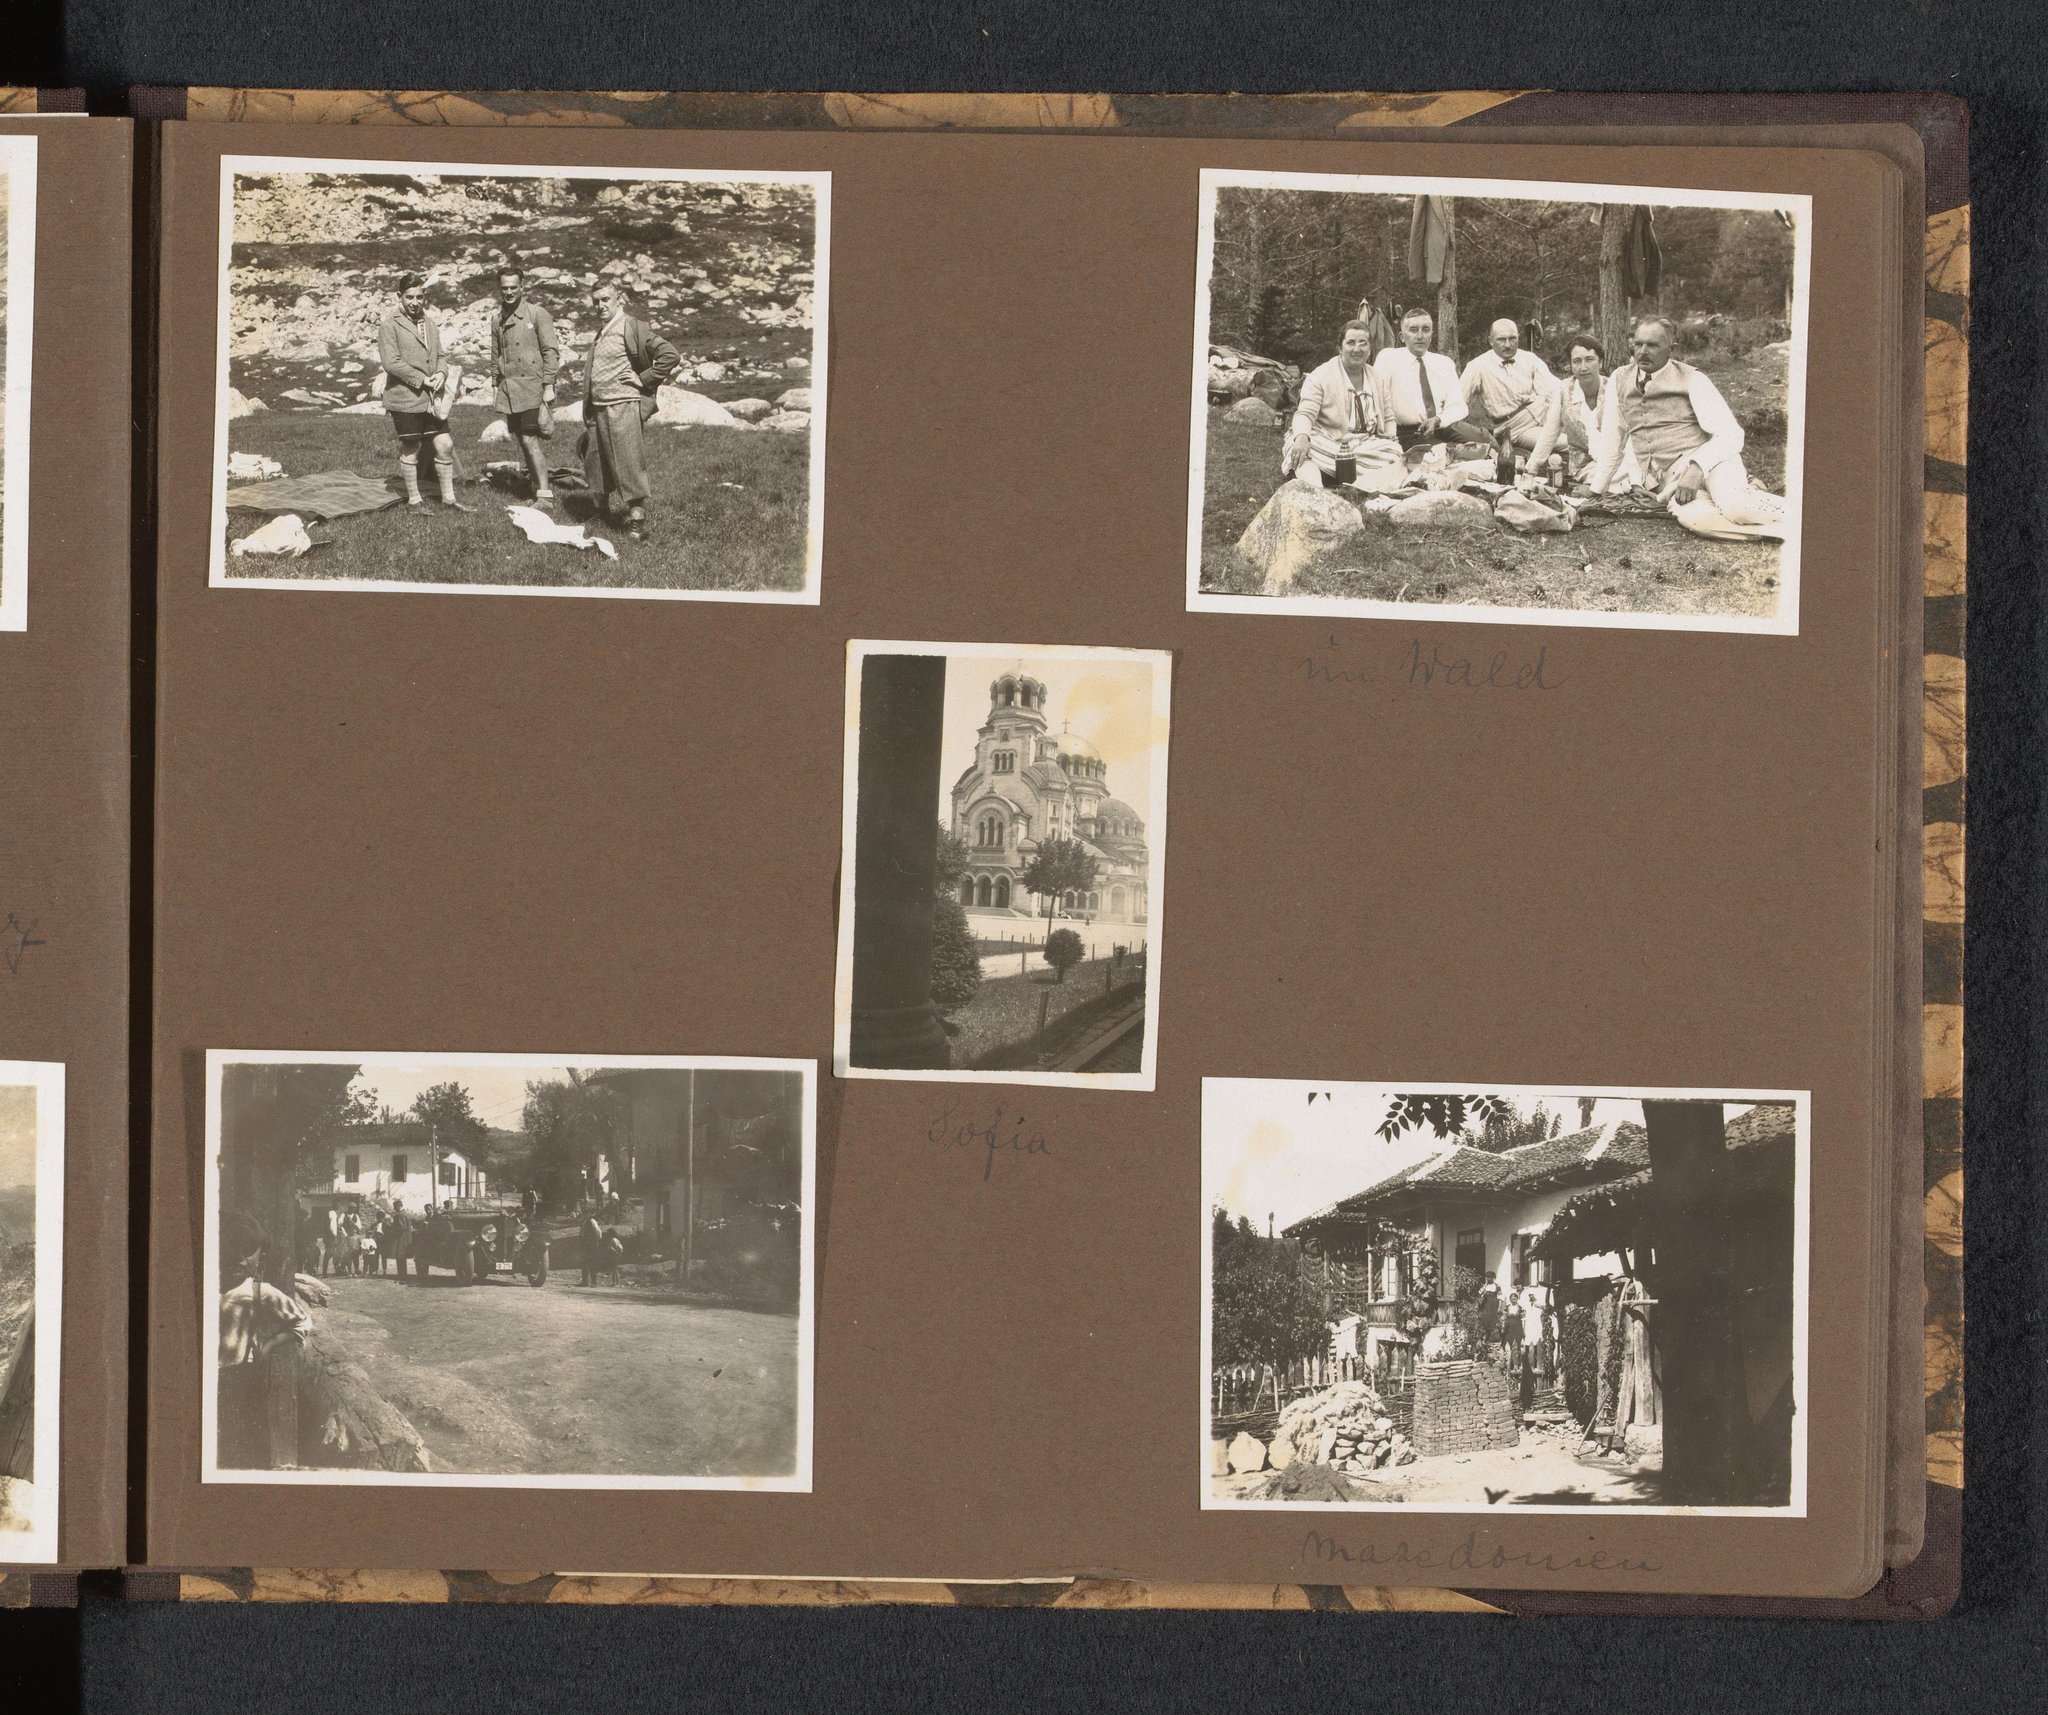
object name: photograph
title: Eugen Wachenheimer en Else Wachenheimer-Moos in Bulgaarse landschappen met onbekende mannen, tijdens een rondreis van Eugen met zijn echtgenote Else Wachenheimer-Moos door Bulgarije, 1926-1927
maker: else wachenheimer-moos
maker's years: 1895-1944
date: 1926-1927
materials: paper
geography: bulgaria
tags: eugen wachenheimer, else wachenheimer-moos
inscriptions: inscription: ‘in Wald Sofia Mazedonien’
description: Albumblad bevat vijf foto's van Eugen Wachenheimer (in lichte bovenkleding), Else Wachenheimer-Moos (met thermosfles) en onbekende personen. Afkomstig uit album half formaat, kartonomslag met koordbinding en lichte veelvormige vormen op voorzijde.